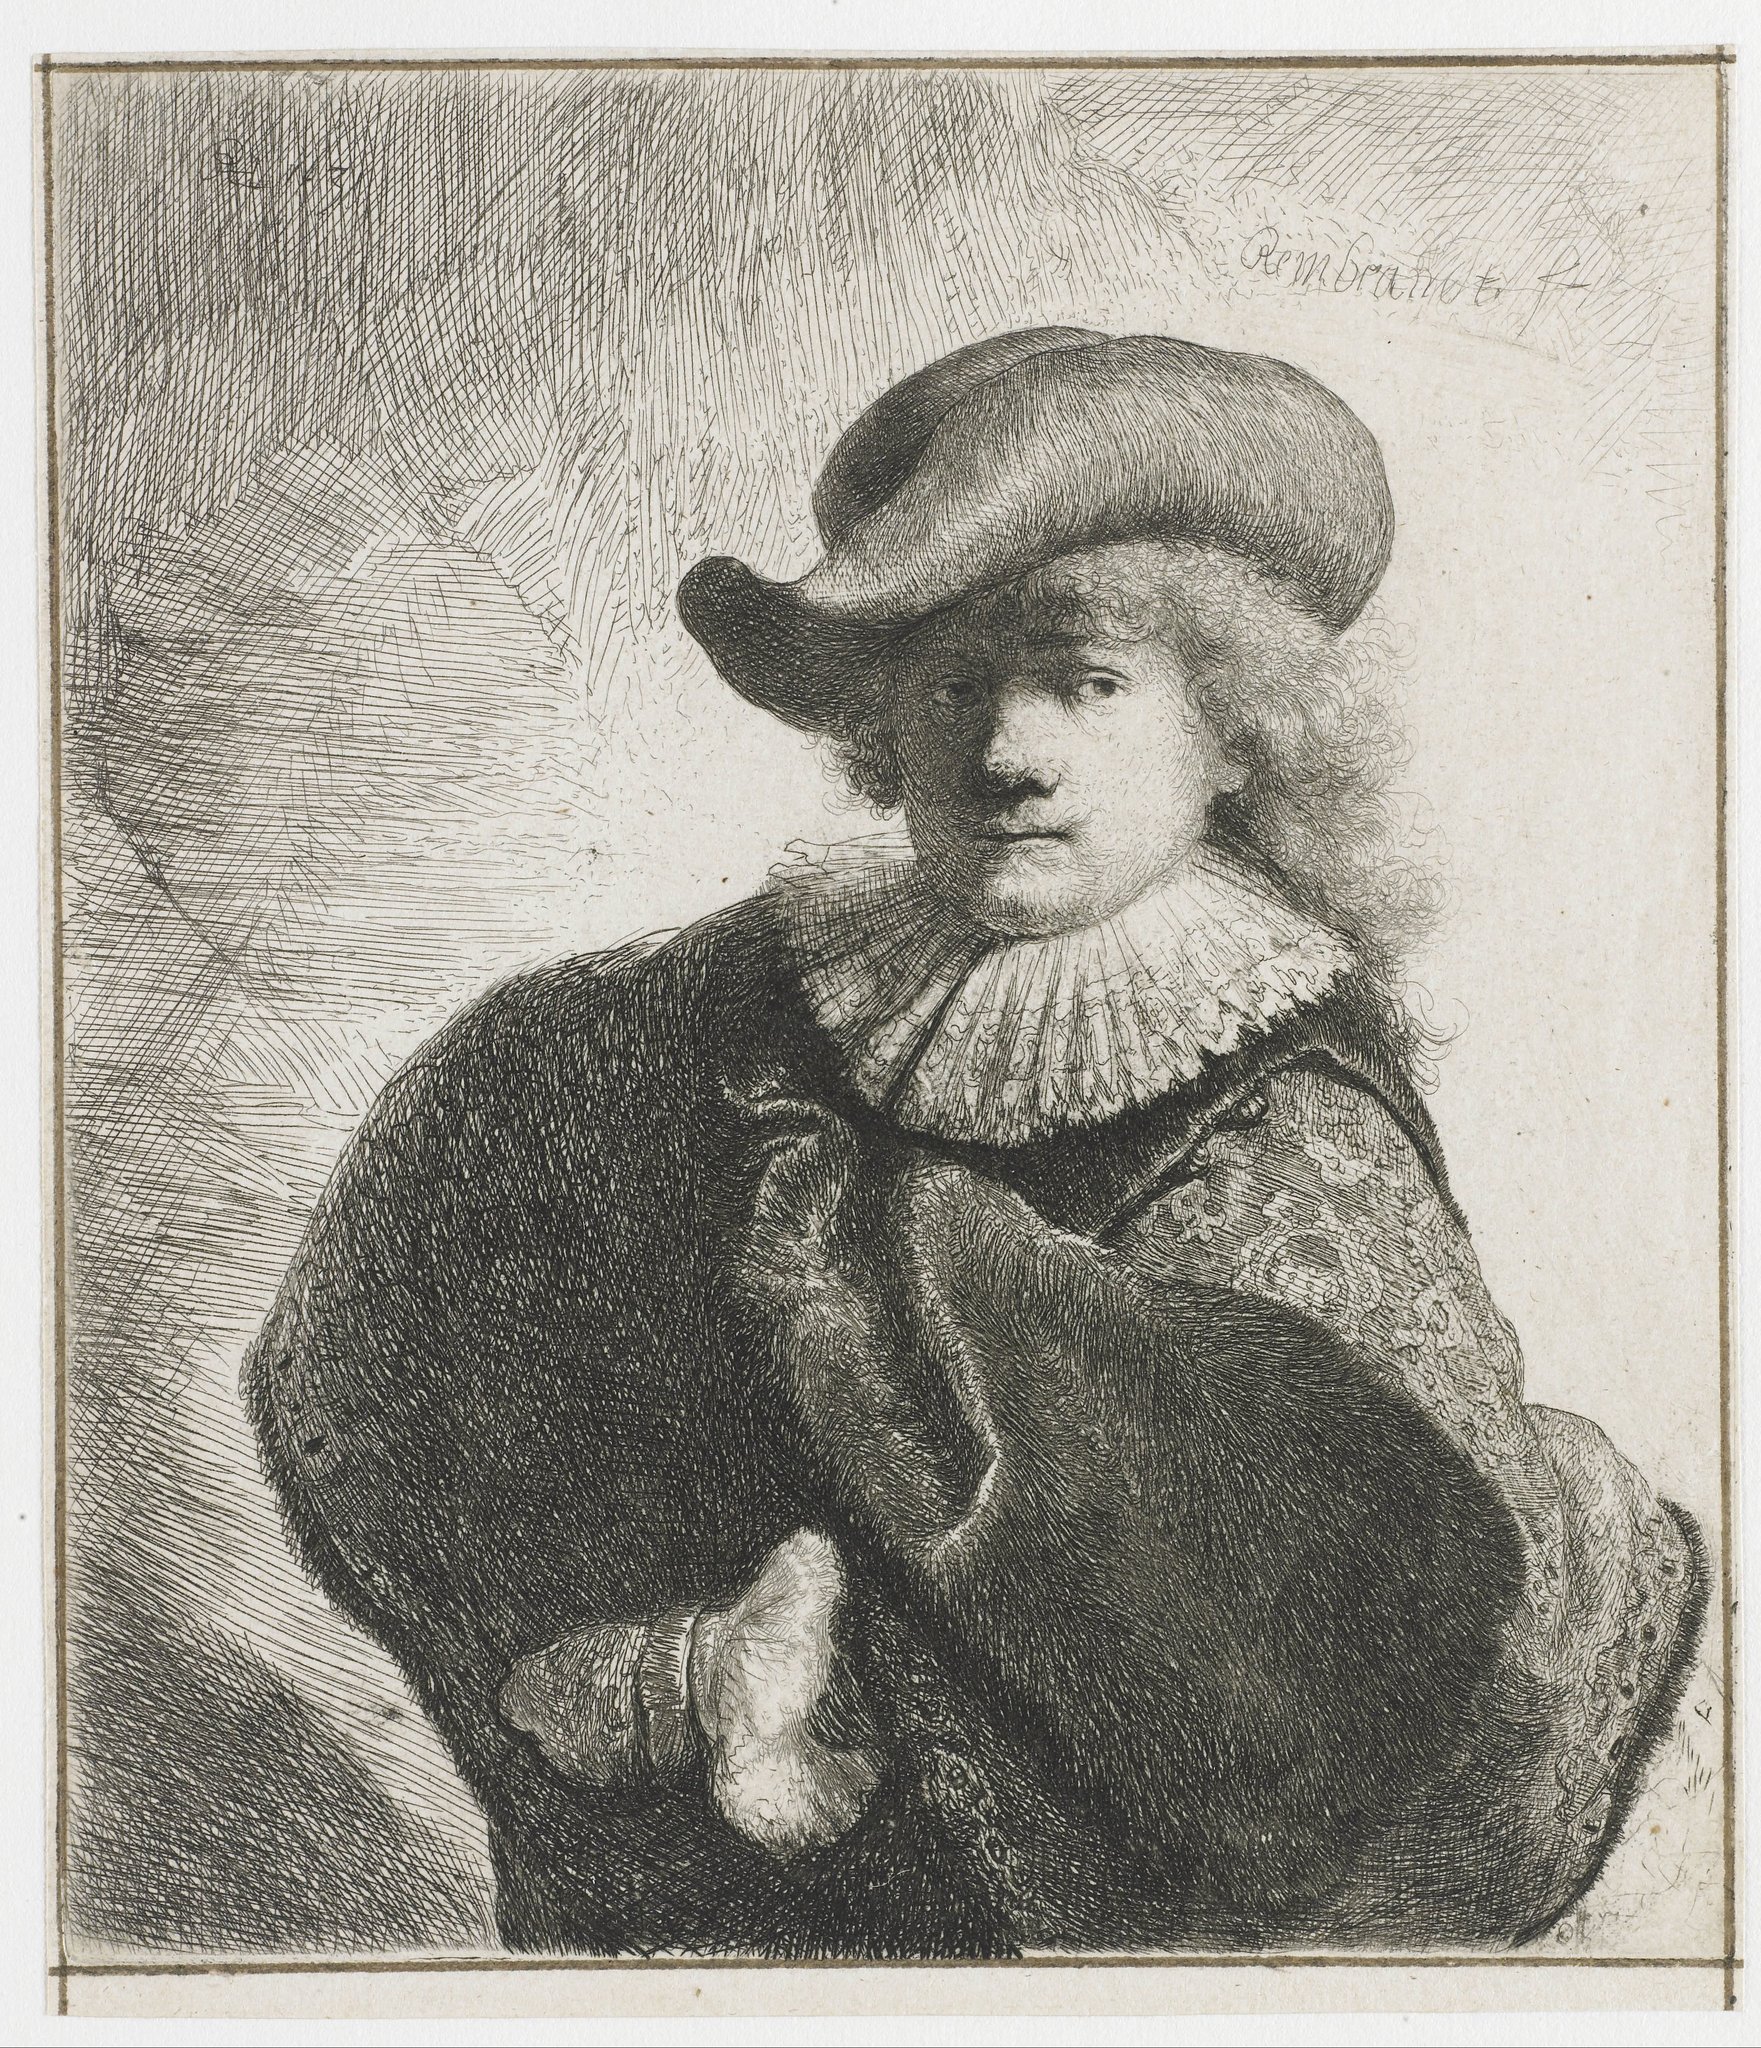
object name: print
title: Self-portrait in a soft hat and a patterned cloak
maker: rembrandt van rijn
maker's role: draughtsman, painter, print maker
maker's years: 1606-1669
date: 1631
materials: ink, paper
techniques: drypoint, etching, pen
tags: leiden, amsterdam, print maker, draughtsman, rembrandt van rijn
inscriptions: signature: ‘Rembrandt f’, collector's mark: Lugt 240, monogram and date: ‘RHL 1631’